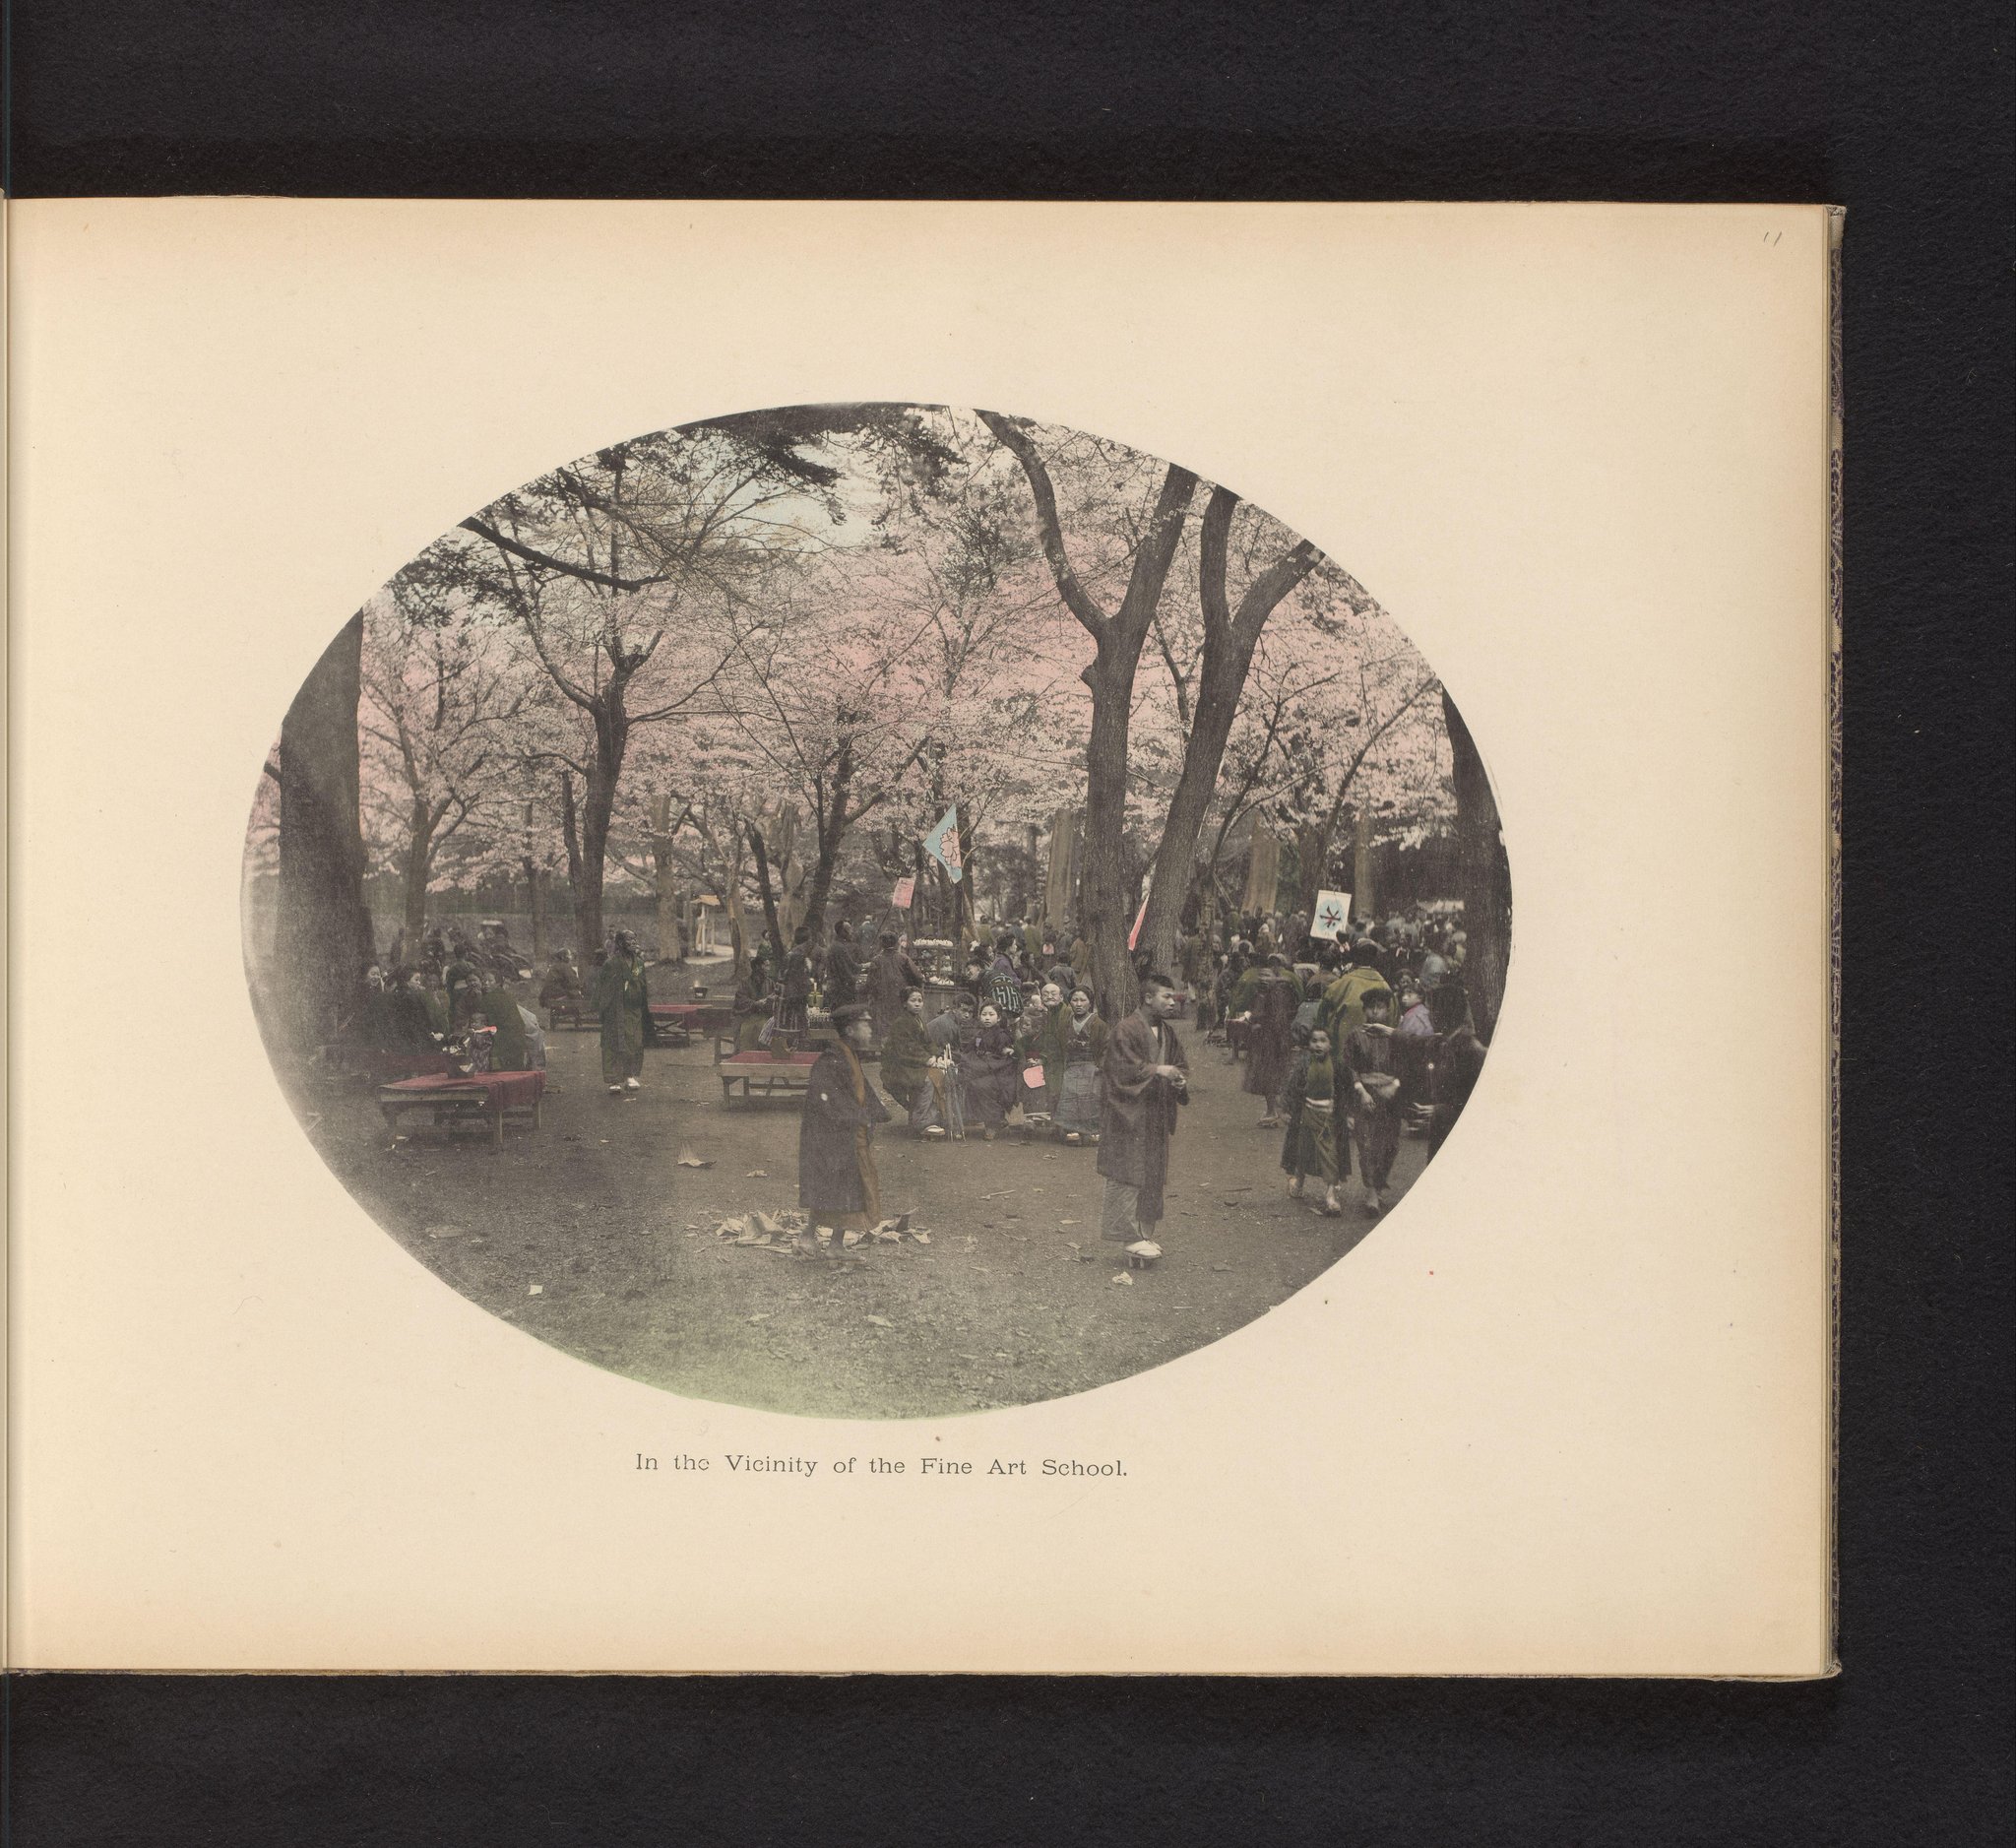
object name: page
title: In the Vicinity of the Fine Art School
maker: kazumasa ogawa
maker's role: auteur, fotograaf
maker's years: 1860-1929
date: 1892-1897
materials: paper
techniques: photograph, hand coloring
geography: uenopark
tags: park, adult woman (+ more than eight persons), adult man (+ more than eight persons)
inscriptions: number: ‘11’